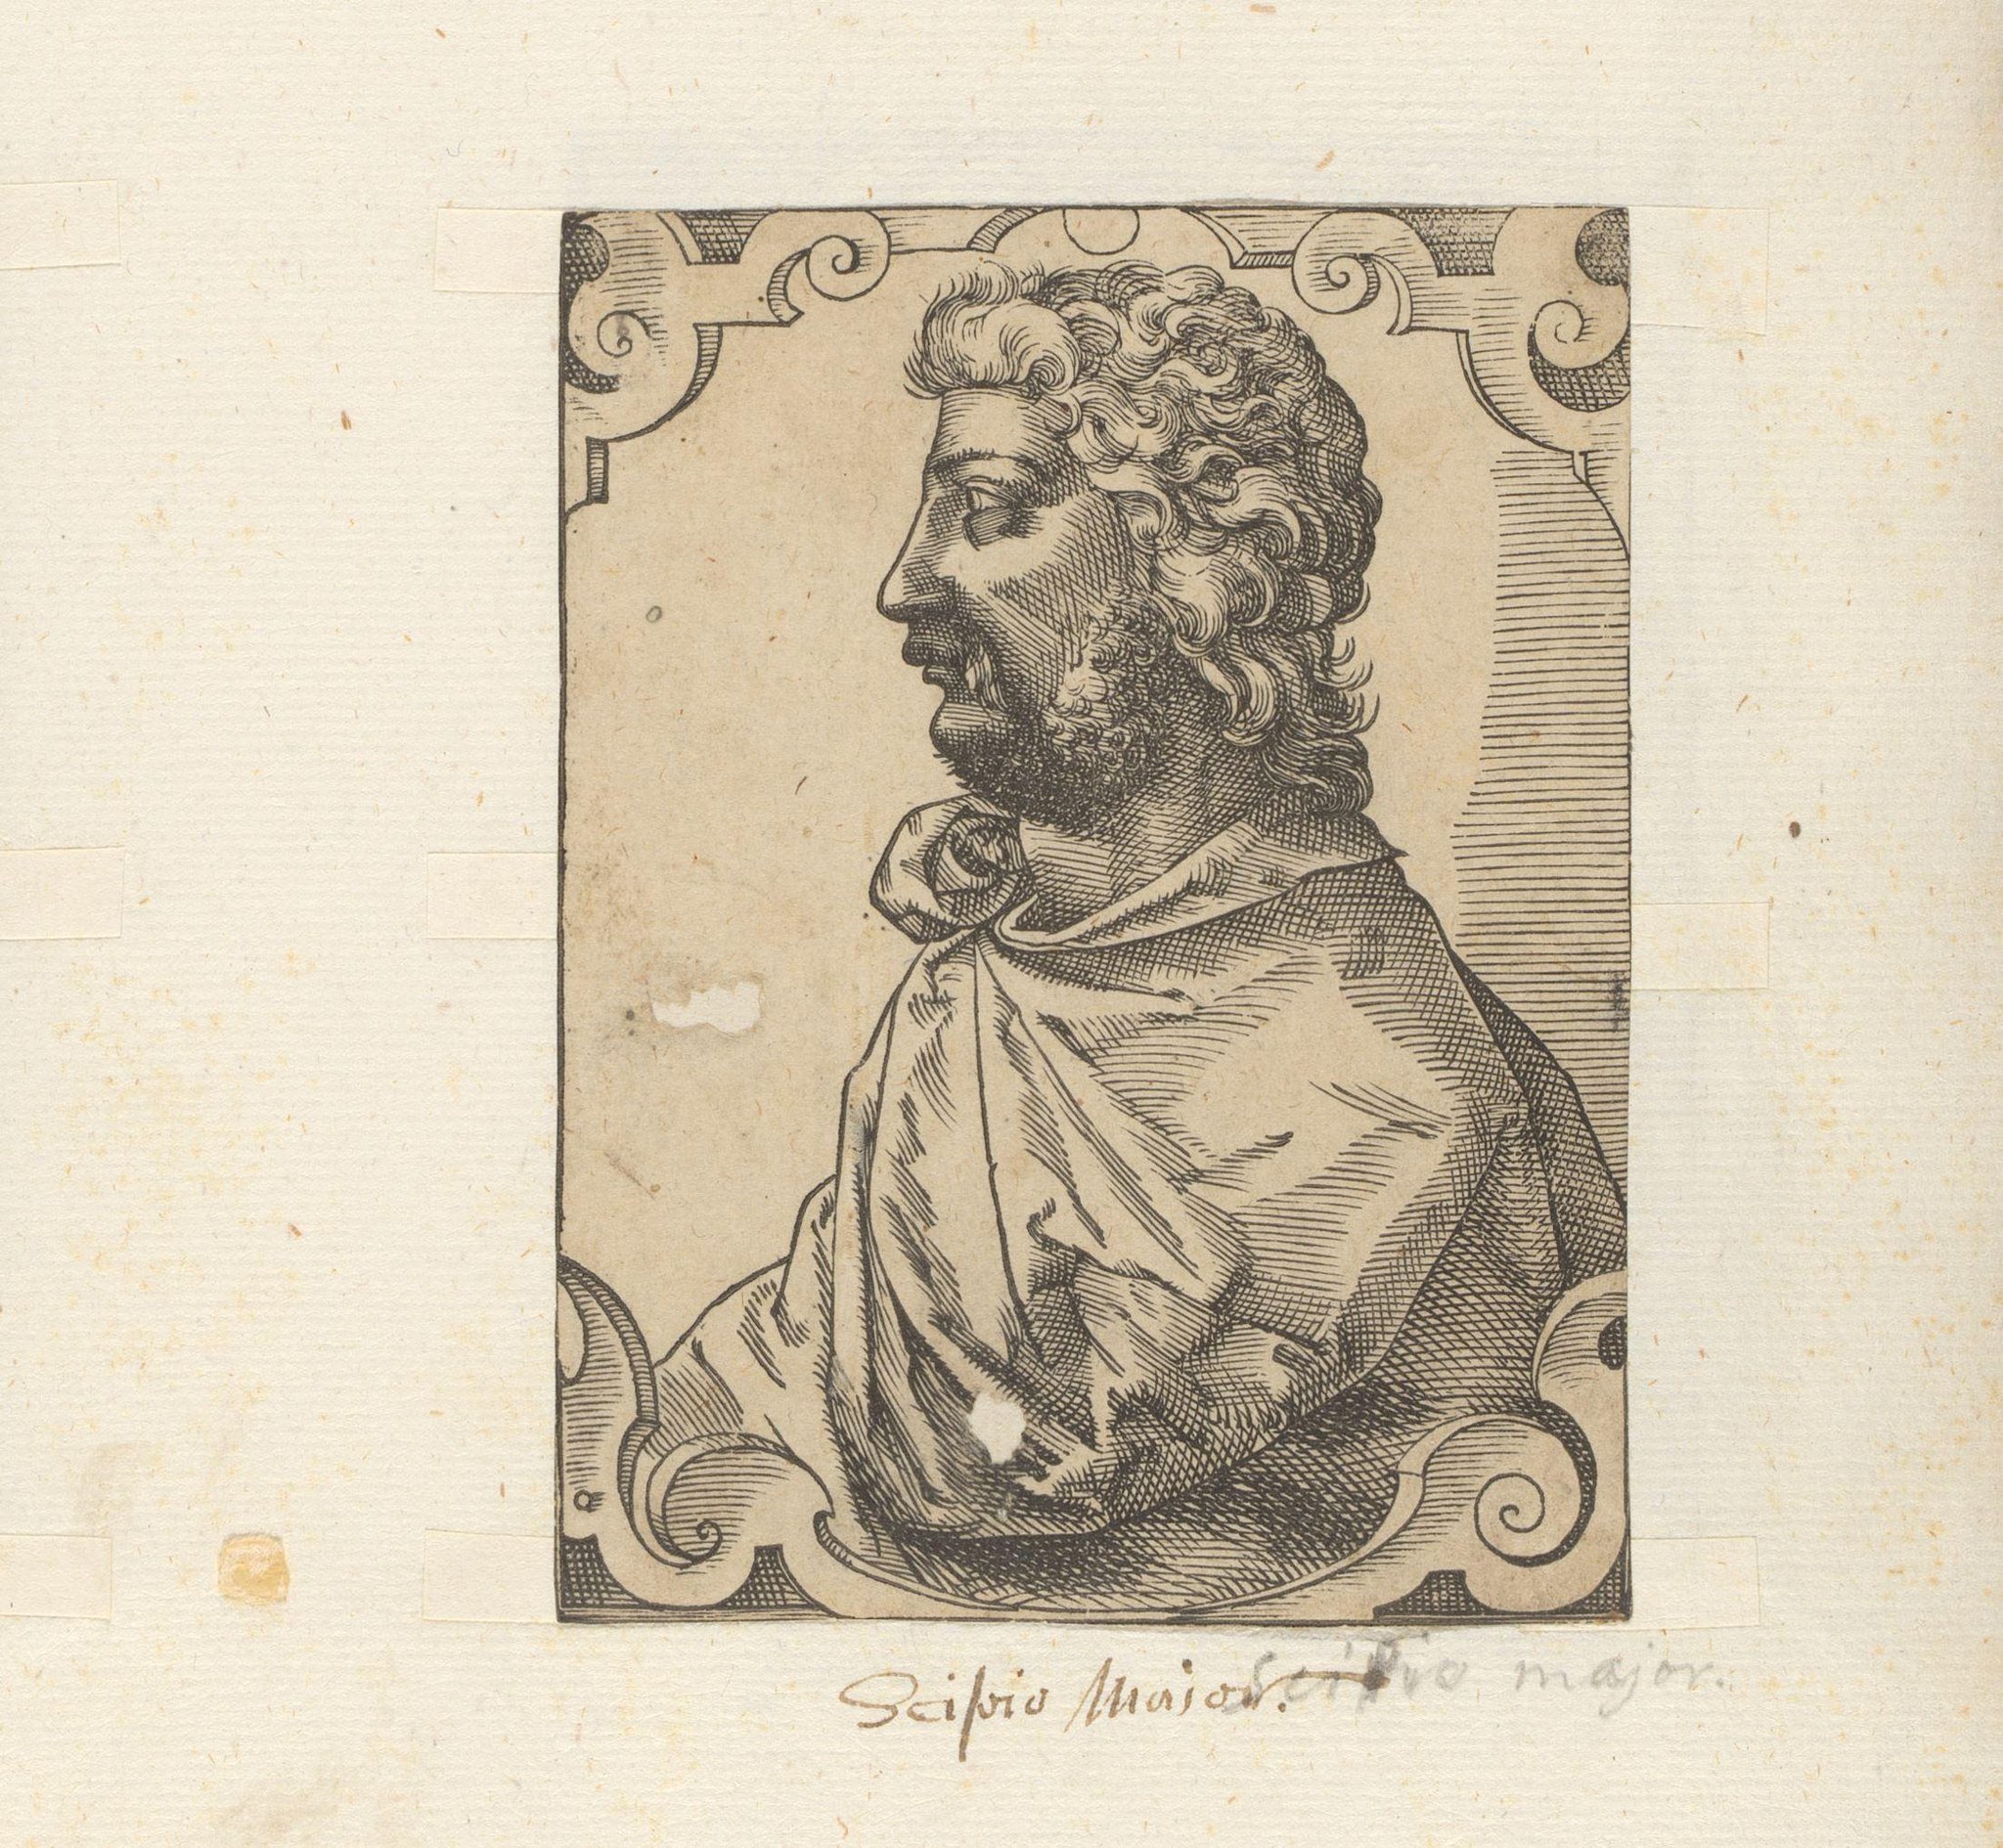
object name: album leaf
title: Portret van Scipio Africanus Maior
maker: Anonymous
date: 1549-1575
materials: paper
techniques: woodcut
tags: rome, politician, commander-in-chief, general, marshal, historical persons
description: Prent gebruikt in: Giovio, Paolo. Elogia Virorum bellica virtute illustrium (...). Bazel: Peter Perna, 1575.